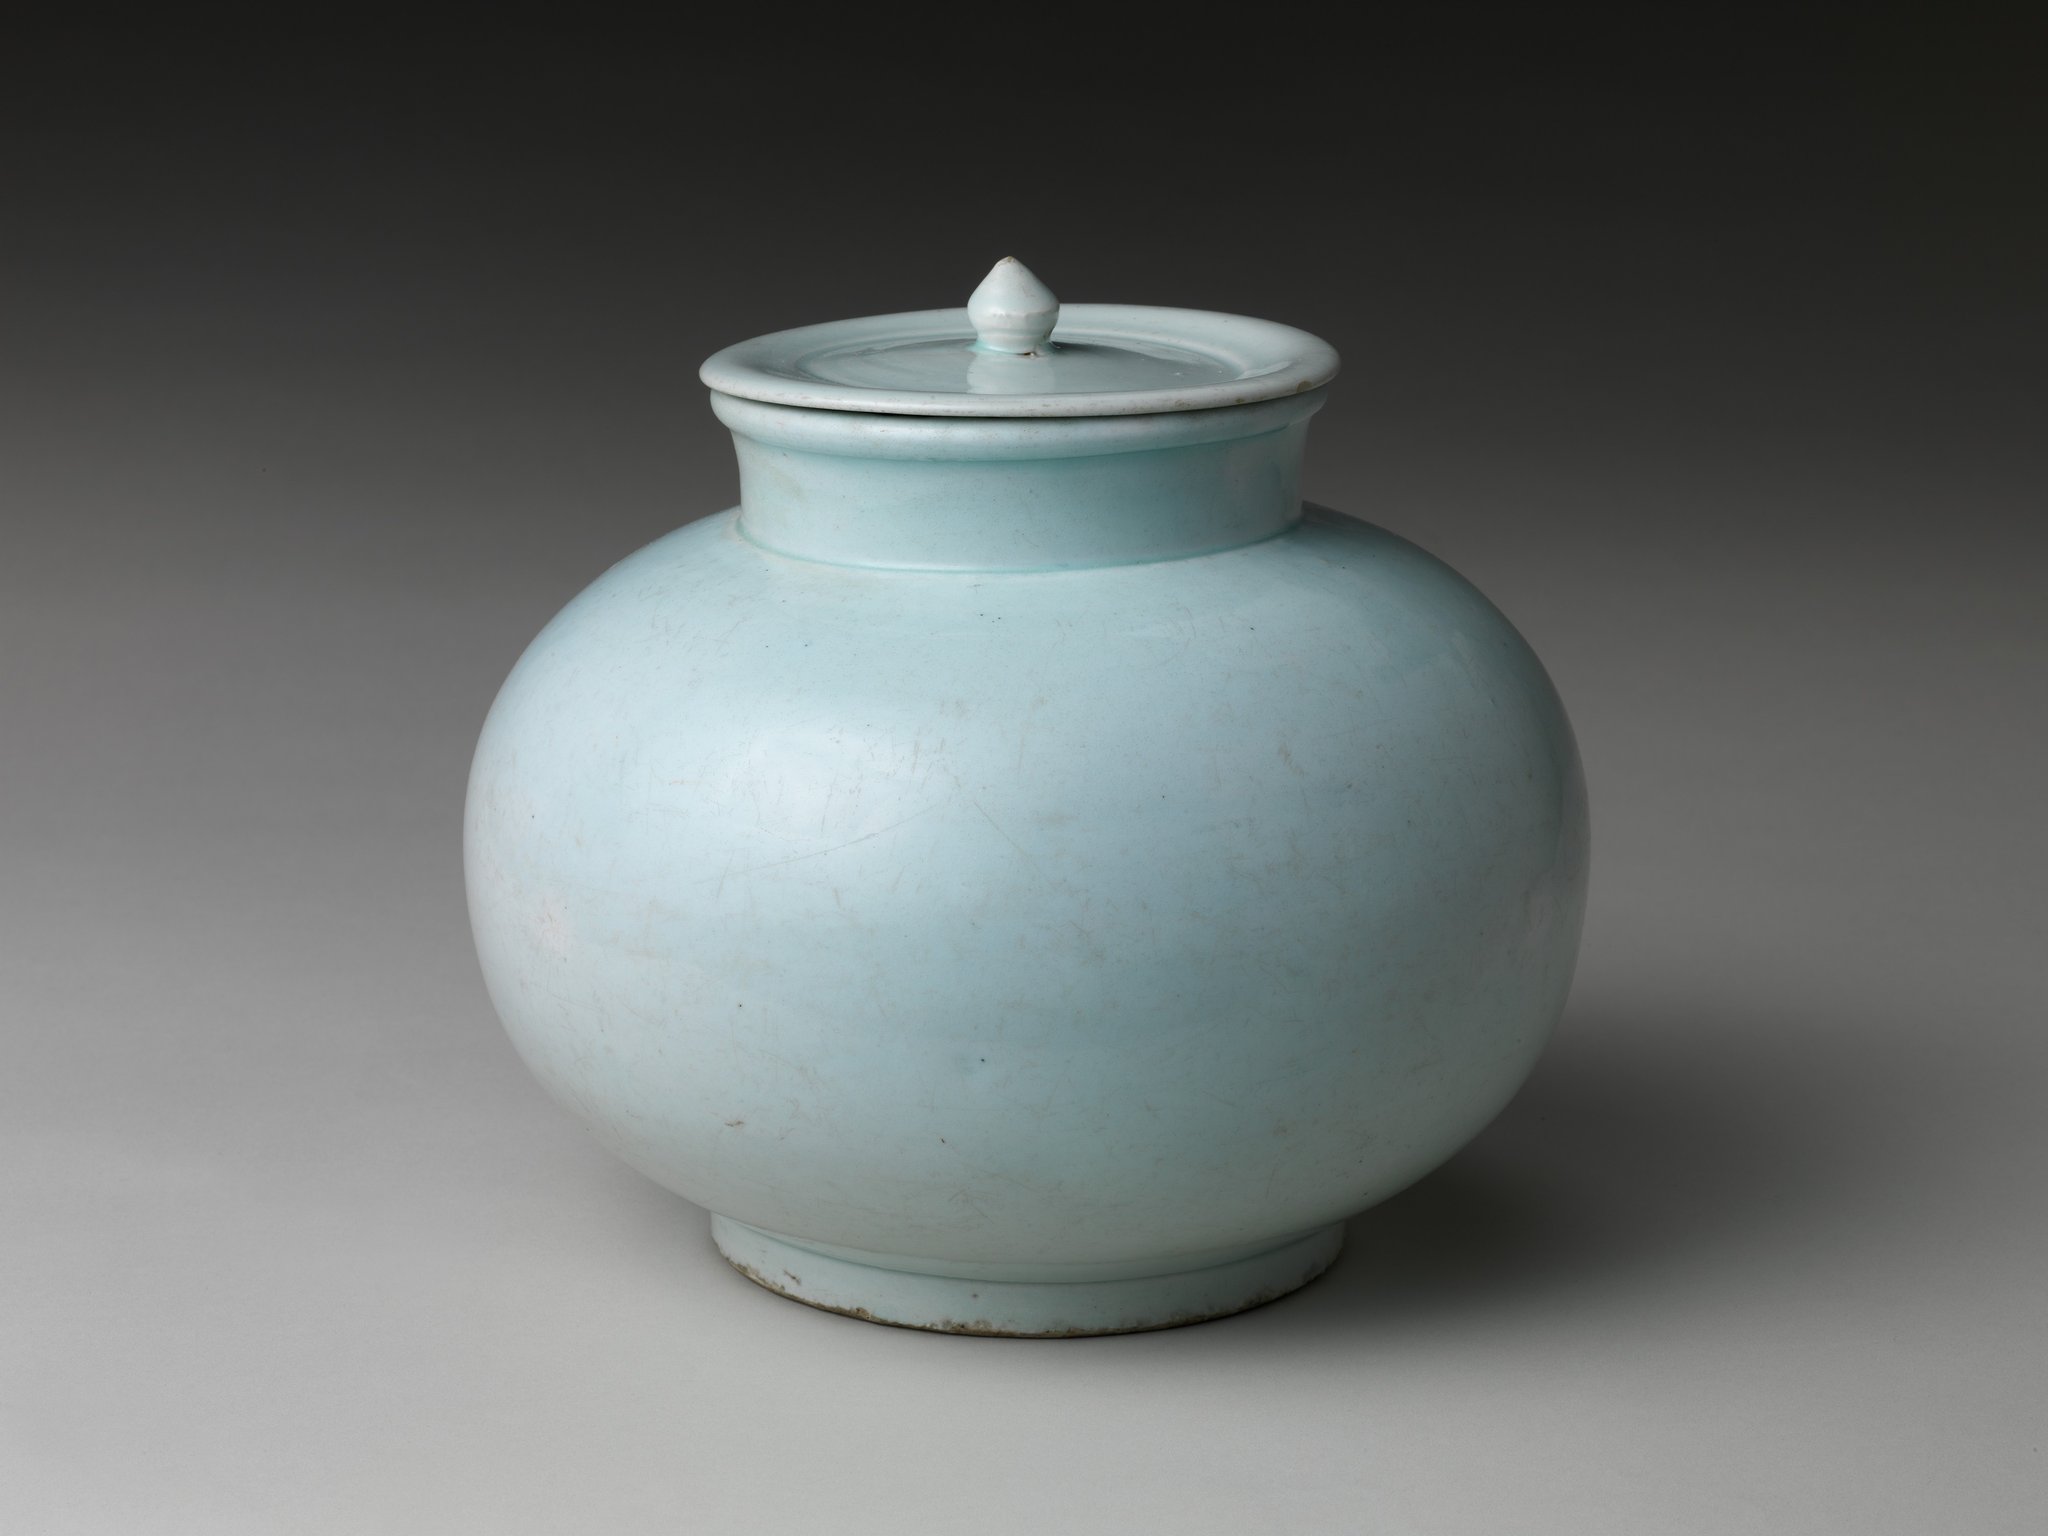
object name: jar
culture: korean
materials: porcelain